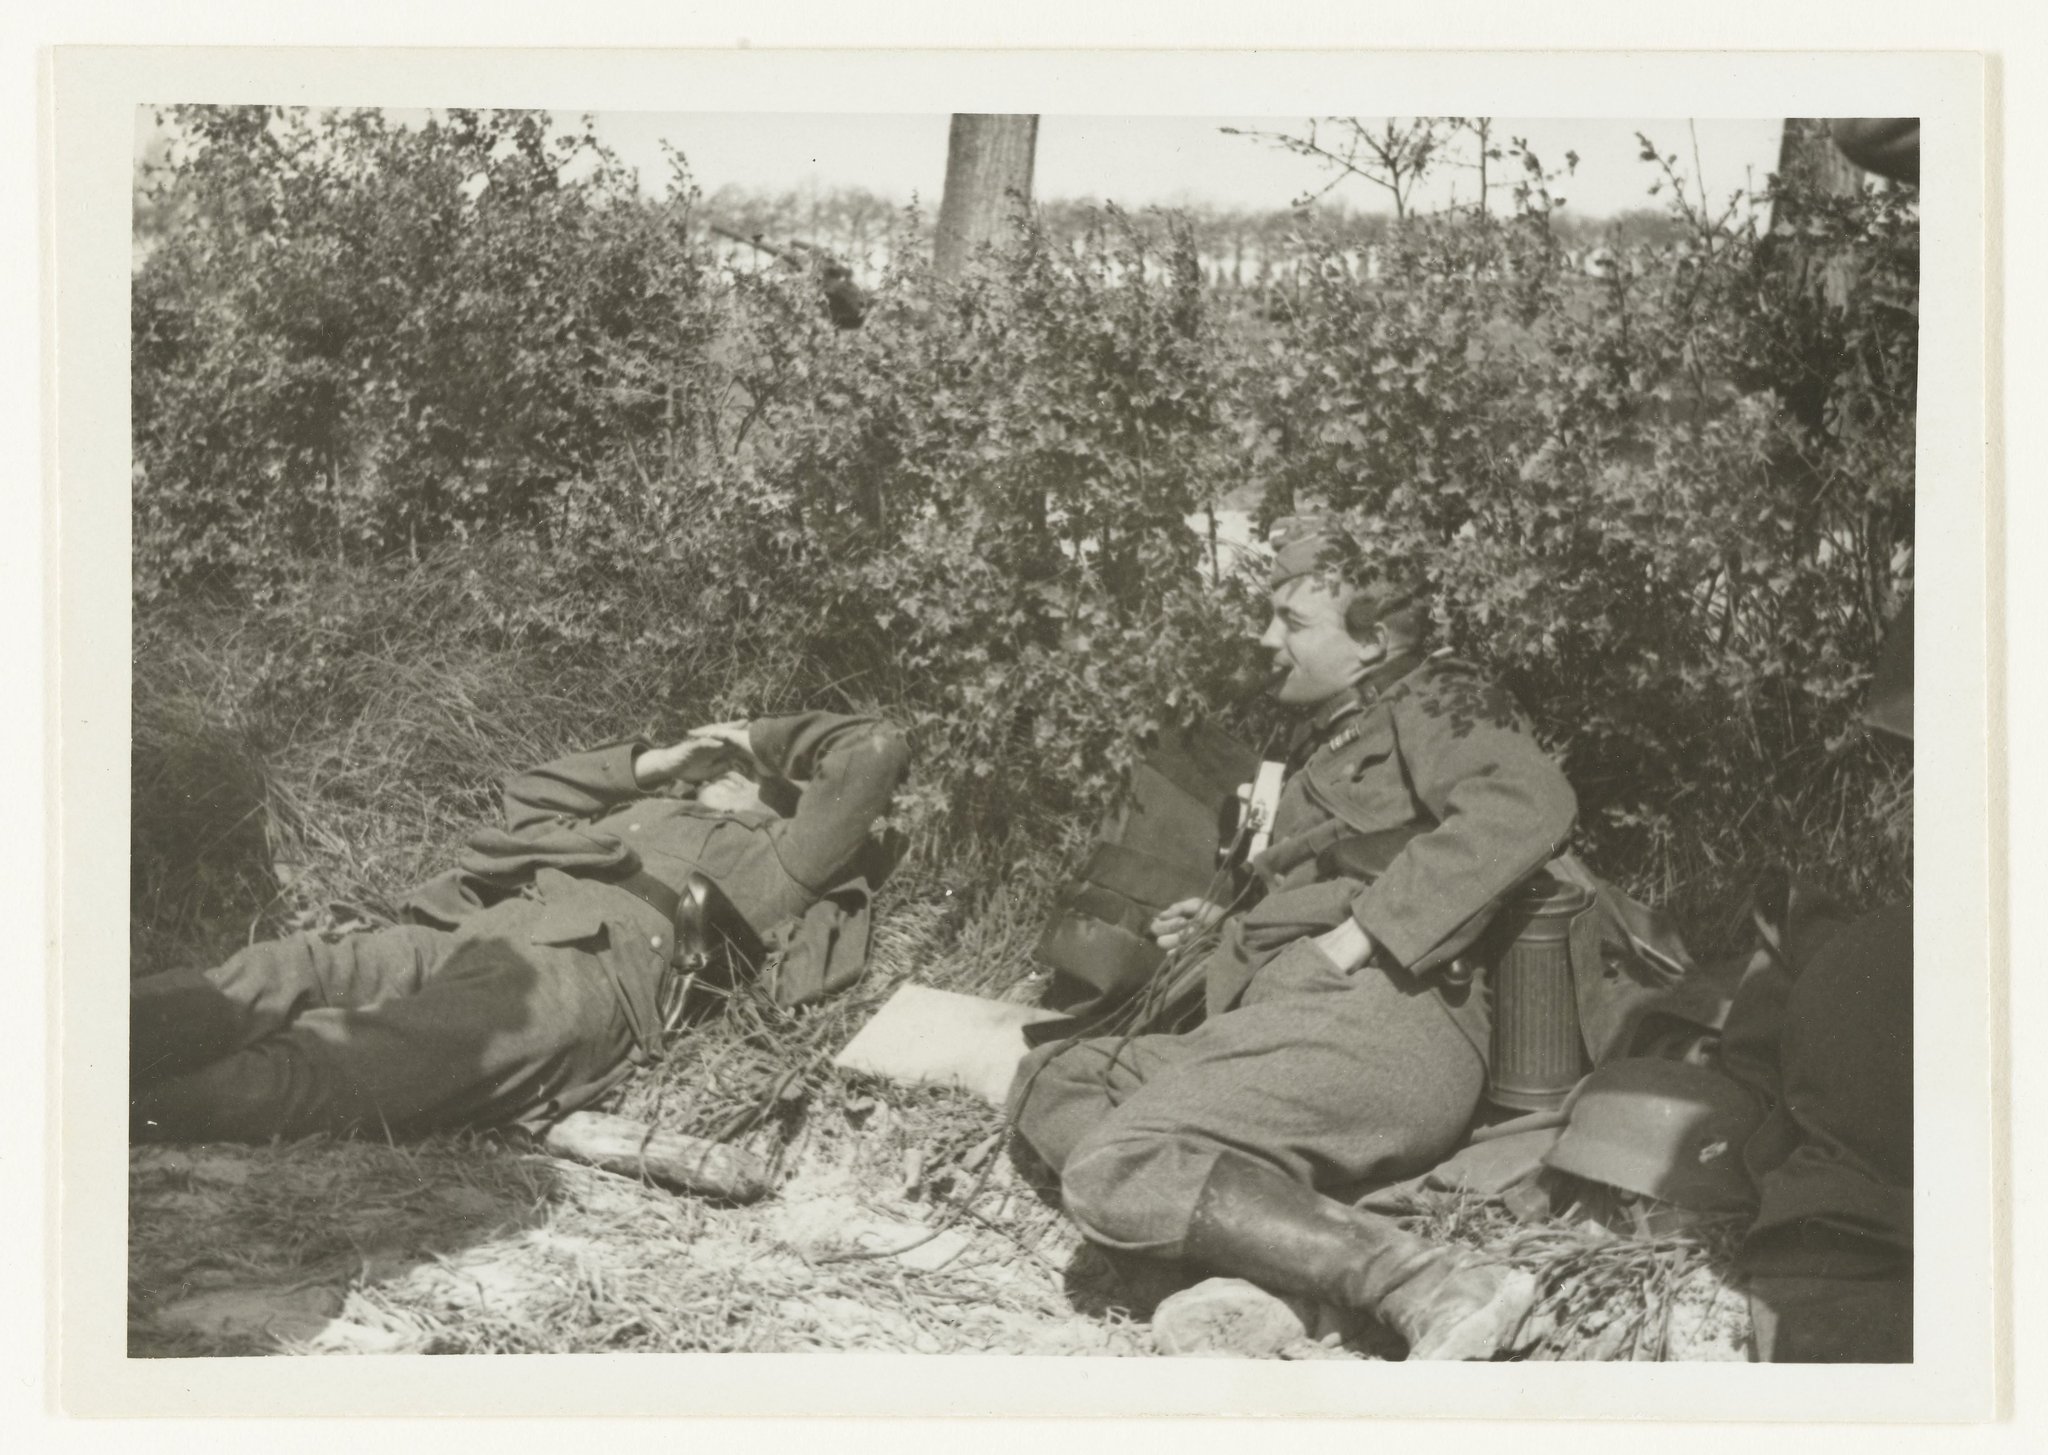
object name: photograph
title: Wehrmacht militairen, telegrafisten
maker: Anonymous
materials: photographic support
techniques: gelatin silver print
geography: beers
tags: radio, wireless, radio broadcasting, occupation ~ war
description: Twee Wehrmacht militairen, telegrafisten, liggen op de grond tussen wat bosjes. Een heeft een koptelefoon op.